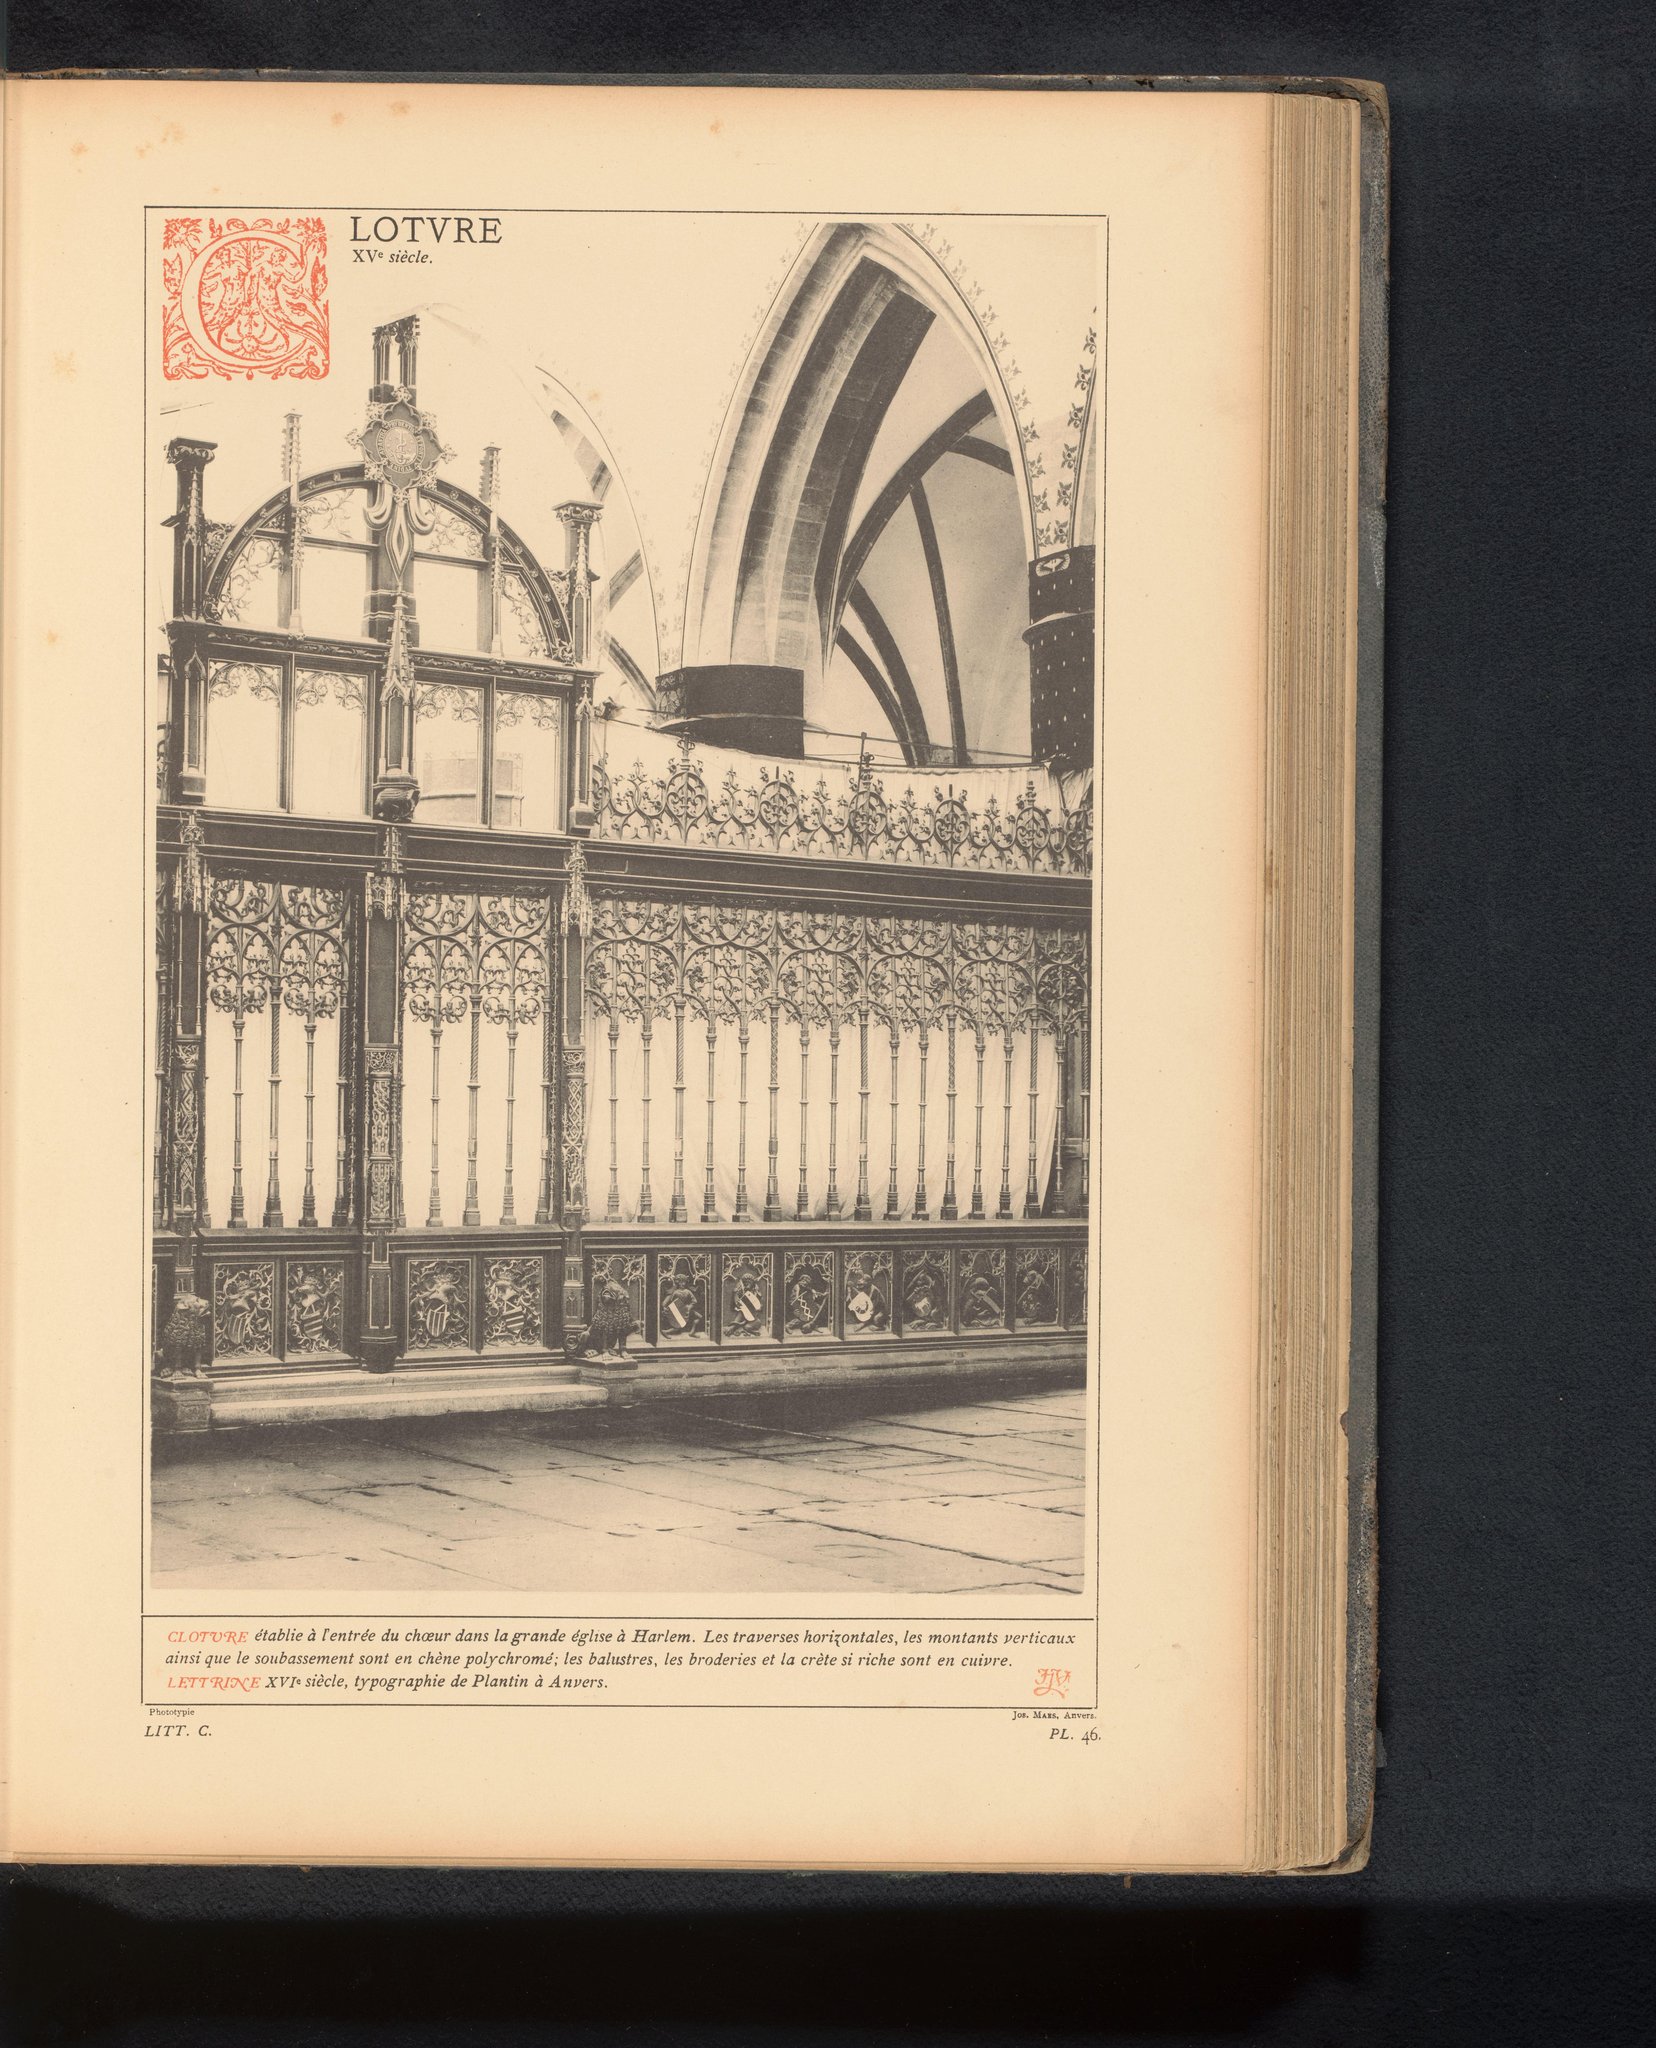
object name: page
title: Cloture, XIe Siècle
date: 1875-1880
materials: paper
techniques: photograph, photolithography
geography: antwerp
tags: parts of church interior: choir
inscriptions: monogram: ‘JJvY’, inscription: ‘LITT. C. - PL. 46’, inscription: ‘Cloture (...)’